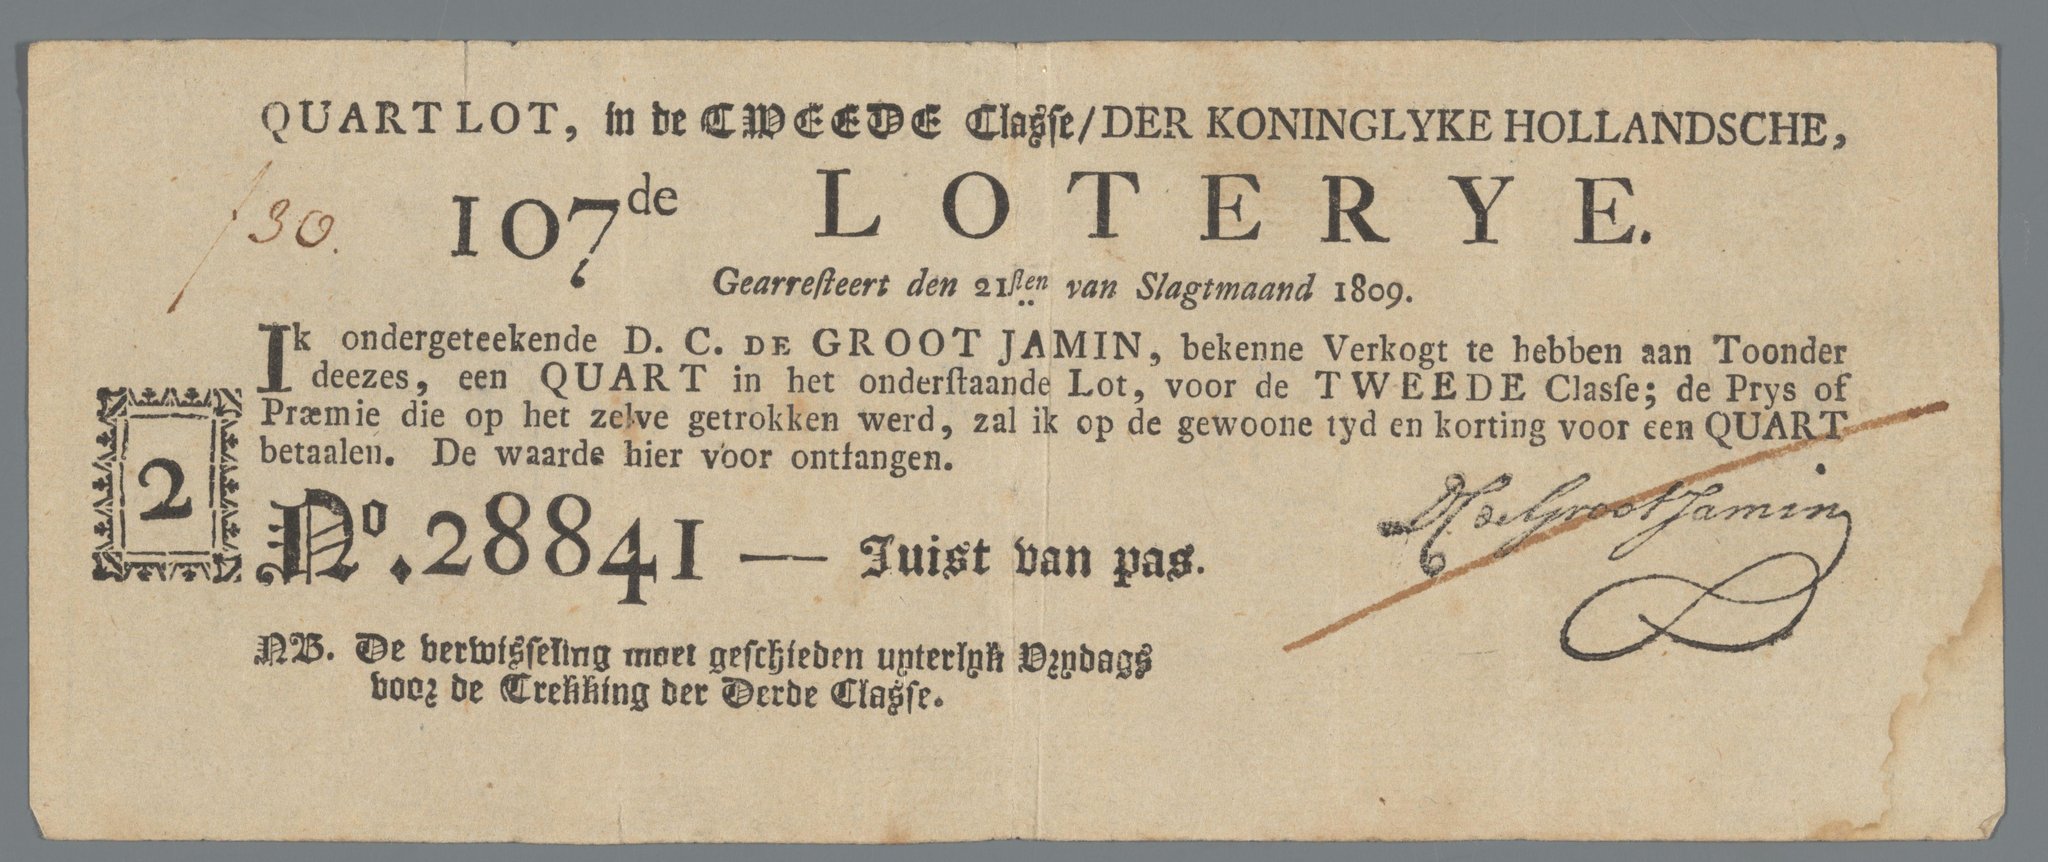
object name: loterijbrief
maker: j.g. de groot jamin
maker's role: schrijver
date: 1809-1811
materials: paper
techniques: printing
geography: amsterdam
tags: netherlands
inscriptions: date